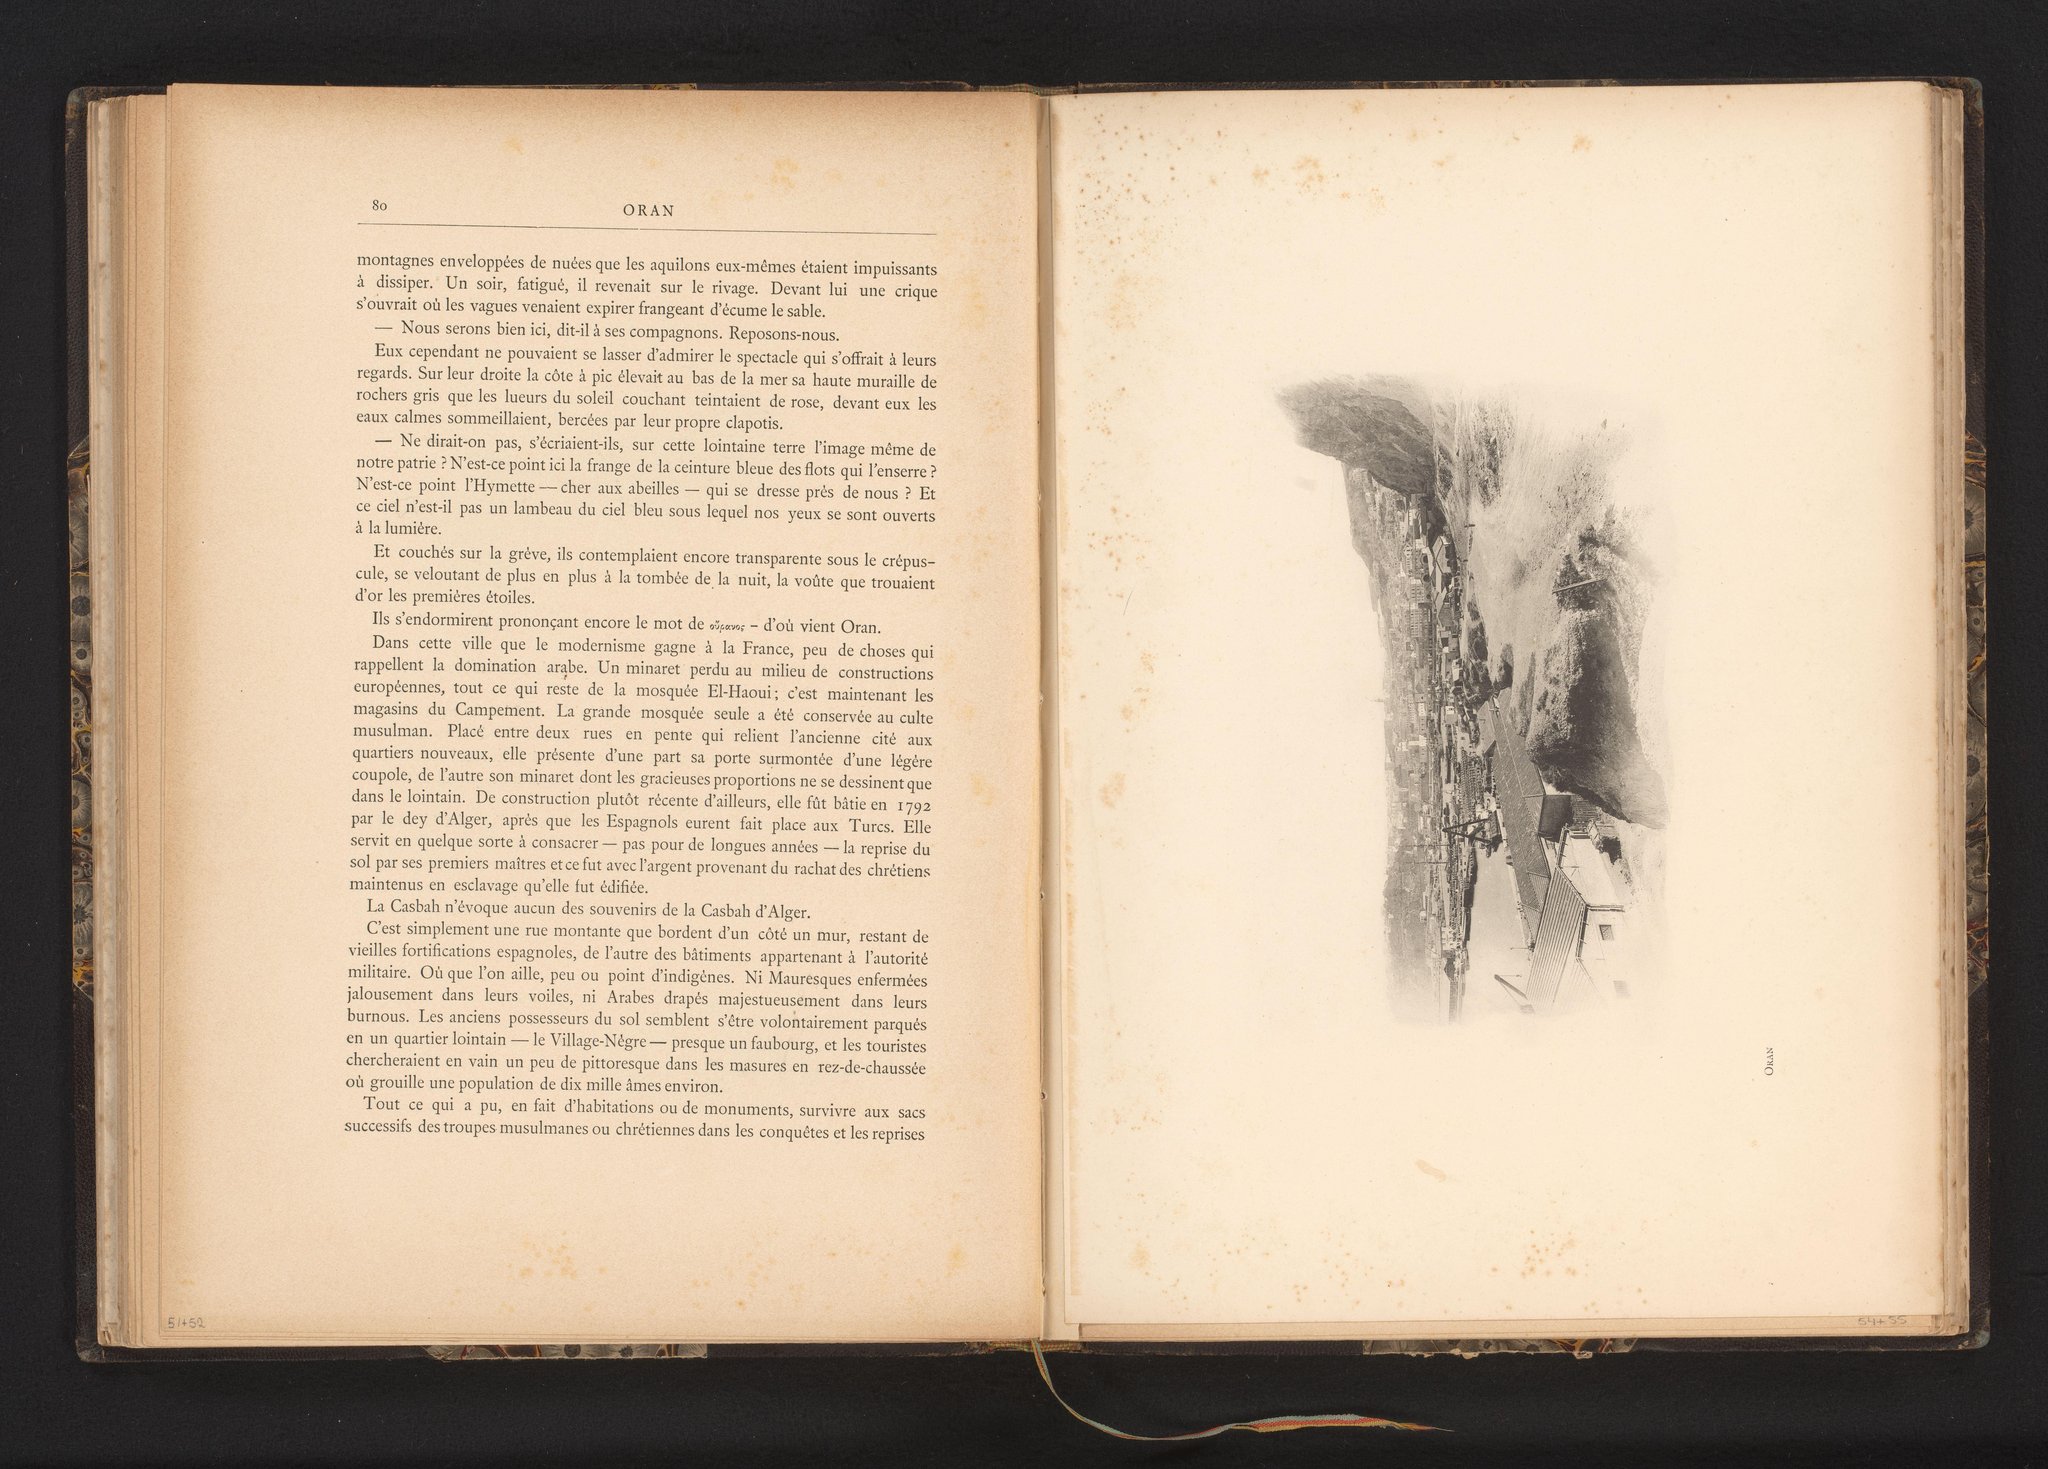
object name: page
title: Gezicht op Oran, Algerije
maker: jules gervais-courtellemont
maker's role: fotograaf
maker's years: 1863-1931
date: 1888-1893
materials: paper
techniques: photograph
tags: prospect of city, town panorama, silhouette of city